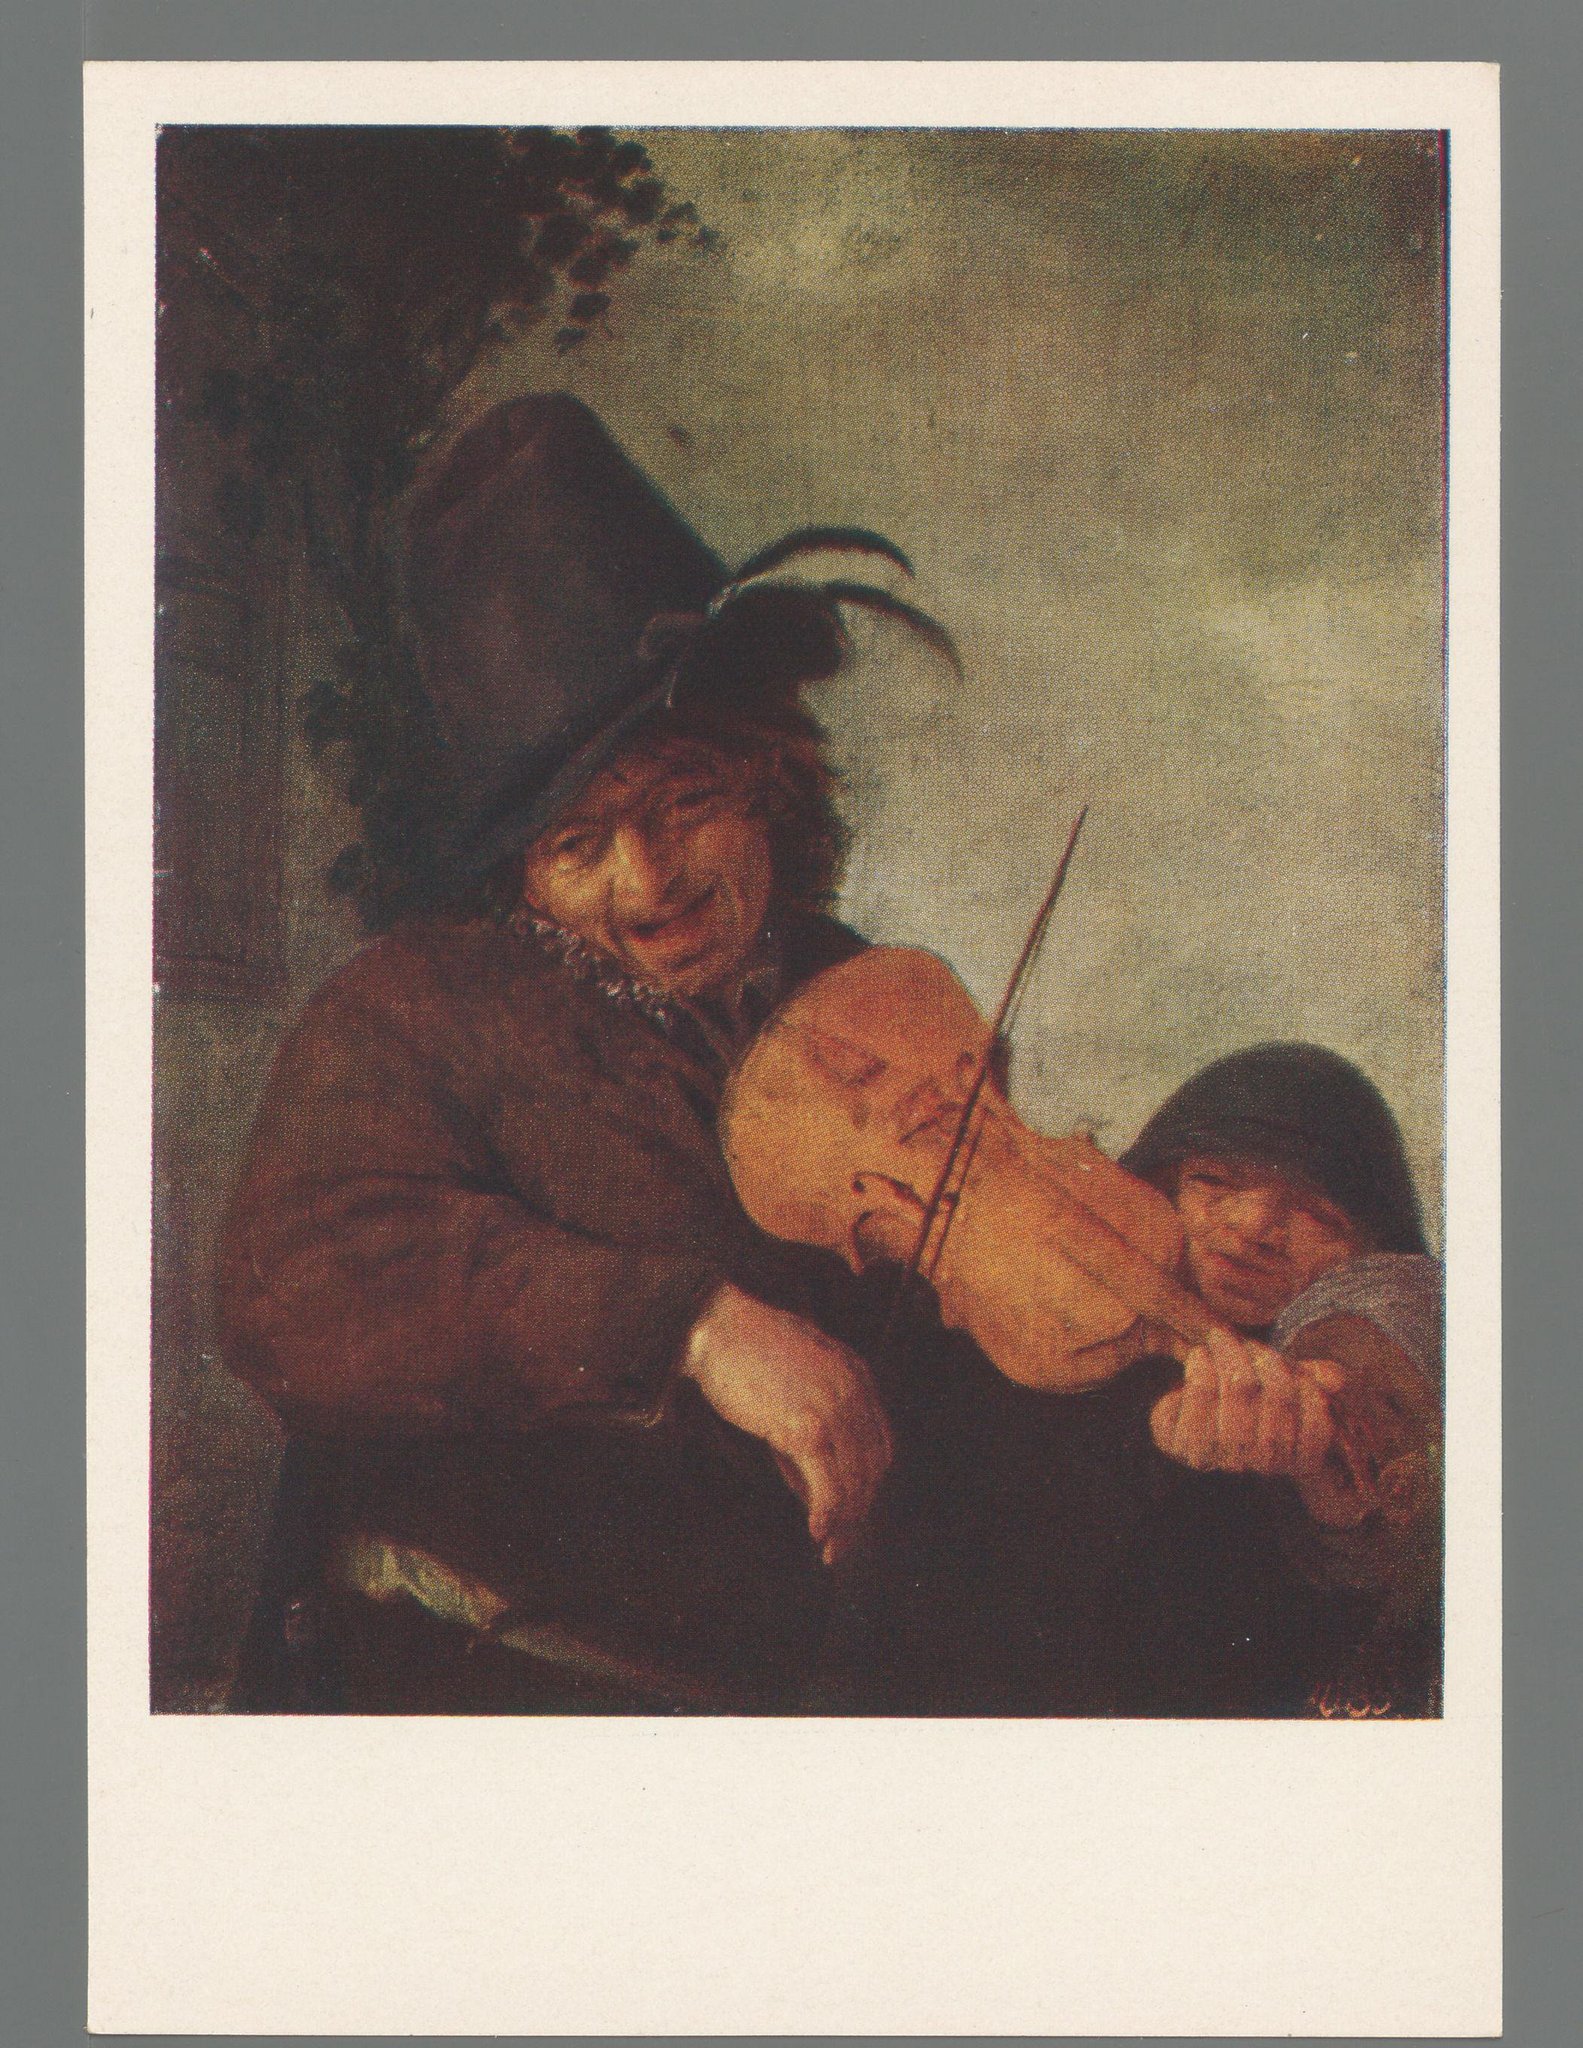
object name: reproduction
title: Adriaen van Ostade - Rondreizende muzikant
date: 1959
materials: cardboard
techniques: color autotype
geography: moscow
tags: permanent exhibition, museum, picture, painting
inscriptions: date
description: De titel op object staat in het Russisch.